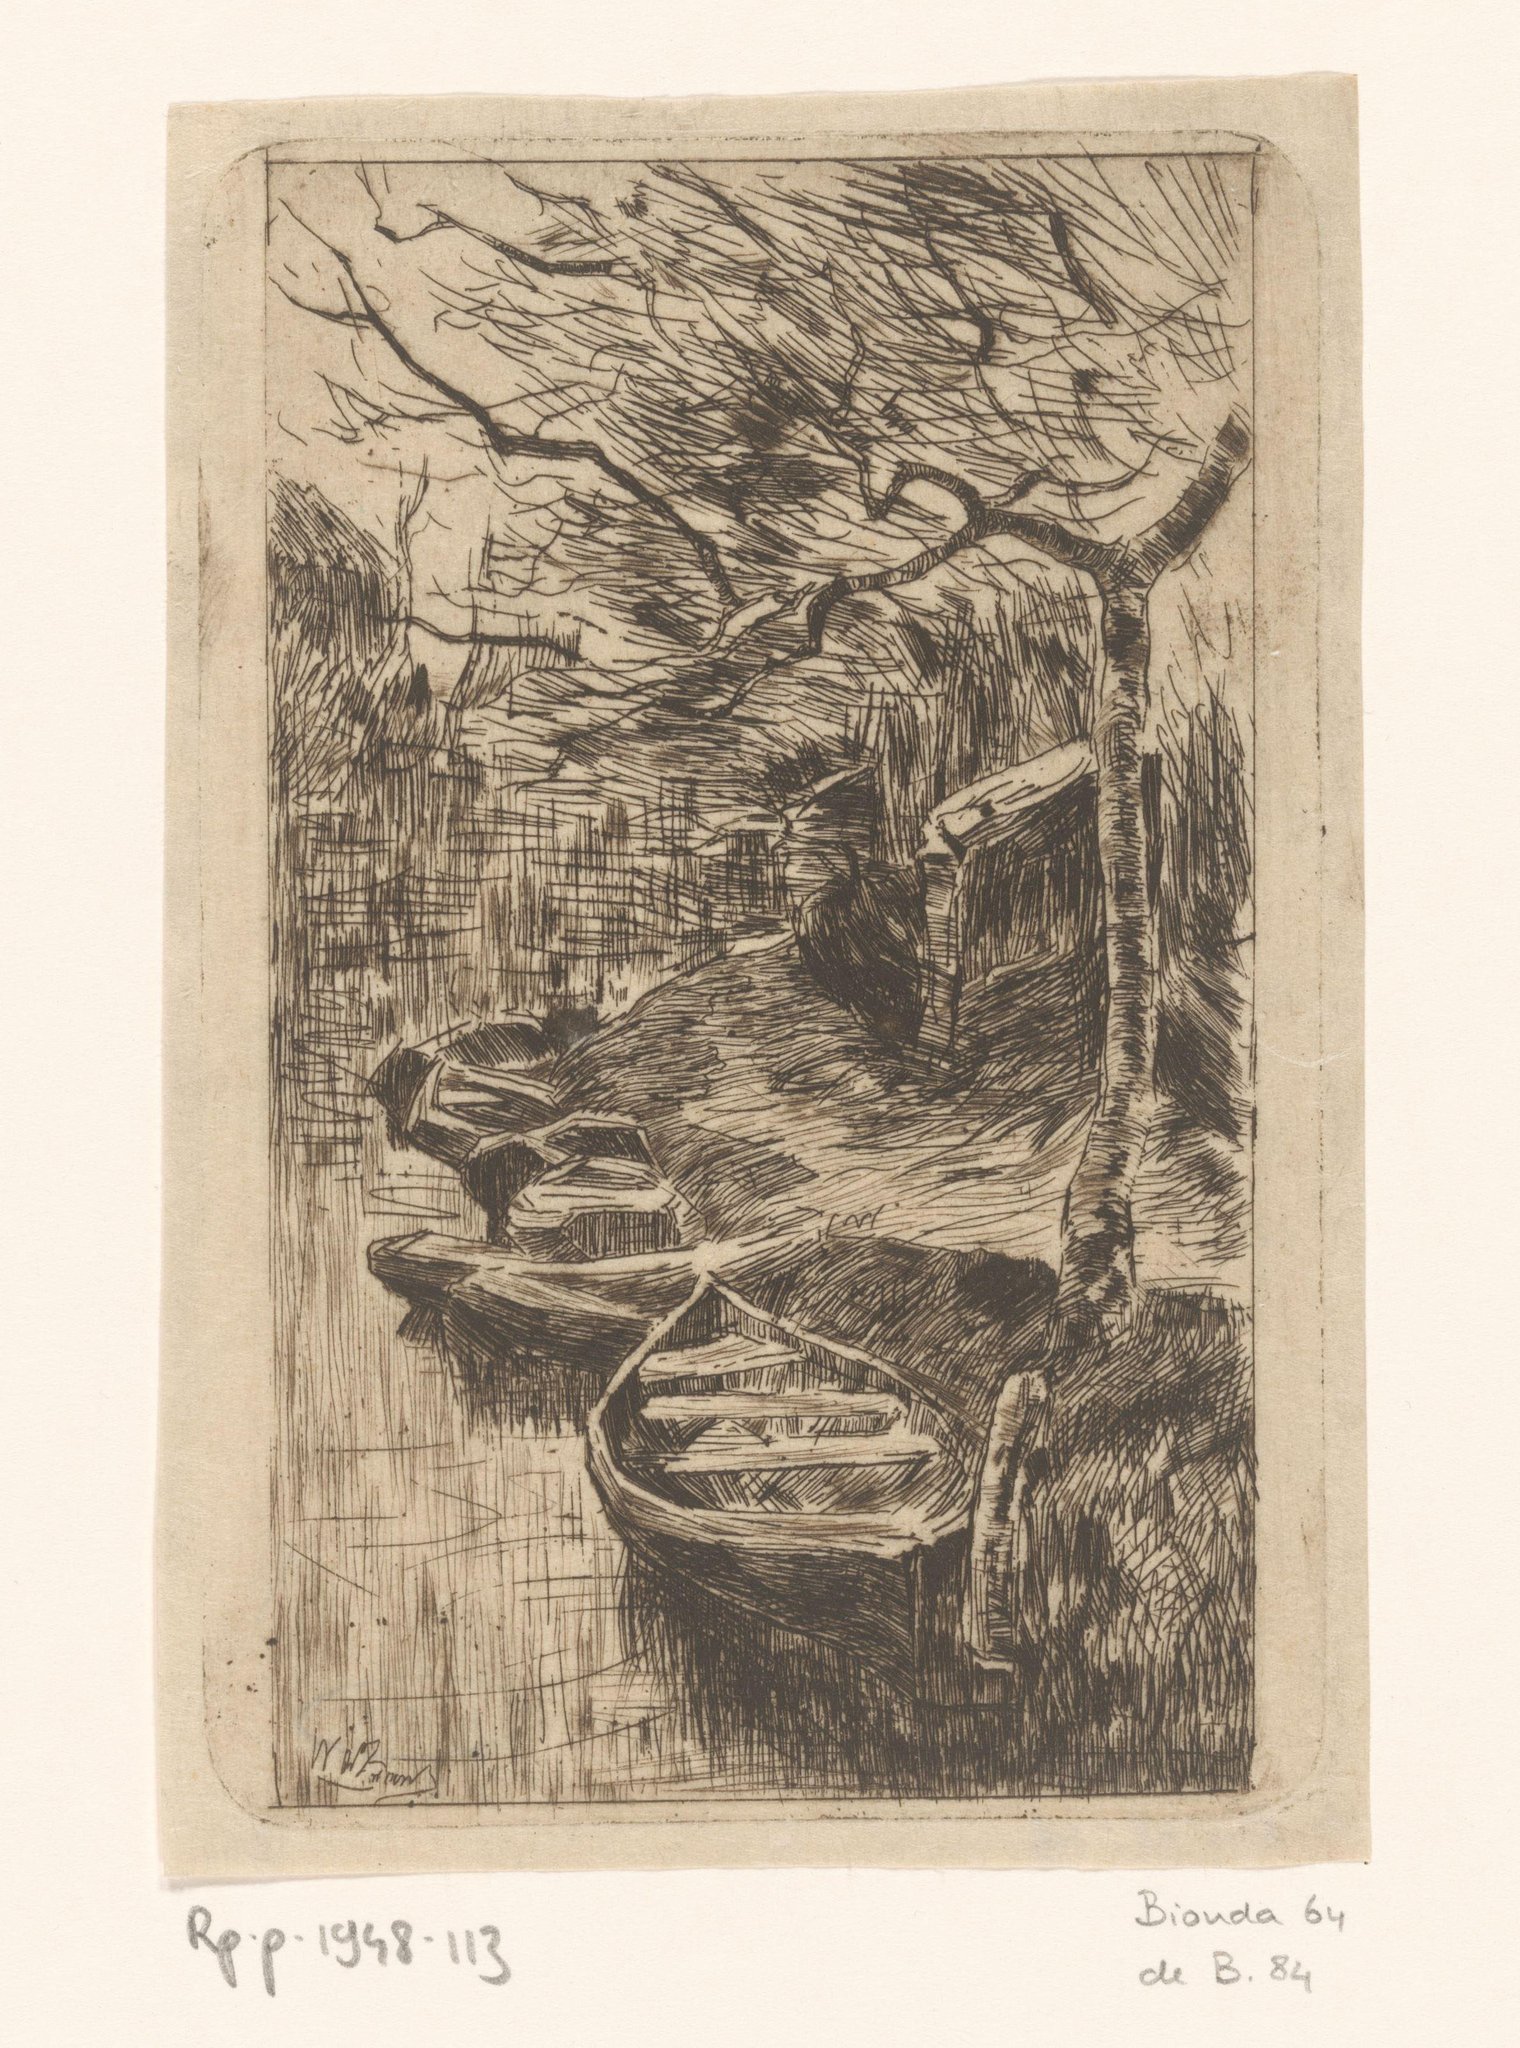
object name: print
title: Vaart met roeiboten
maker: willem de zwart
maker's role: draughtsman, painter, print maker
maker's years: 1862-1931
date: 1896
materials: paper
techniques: drypoint, etching, intaglio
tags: canal, rowing-boat, canoe, etc.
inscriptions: collector's mark: Lugt 2228